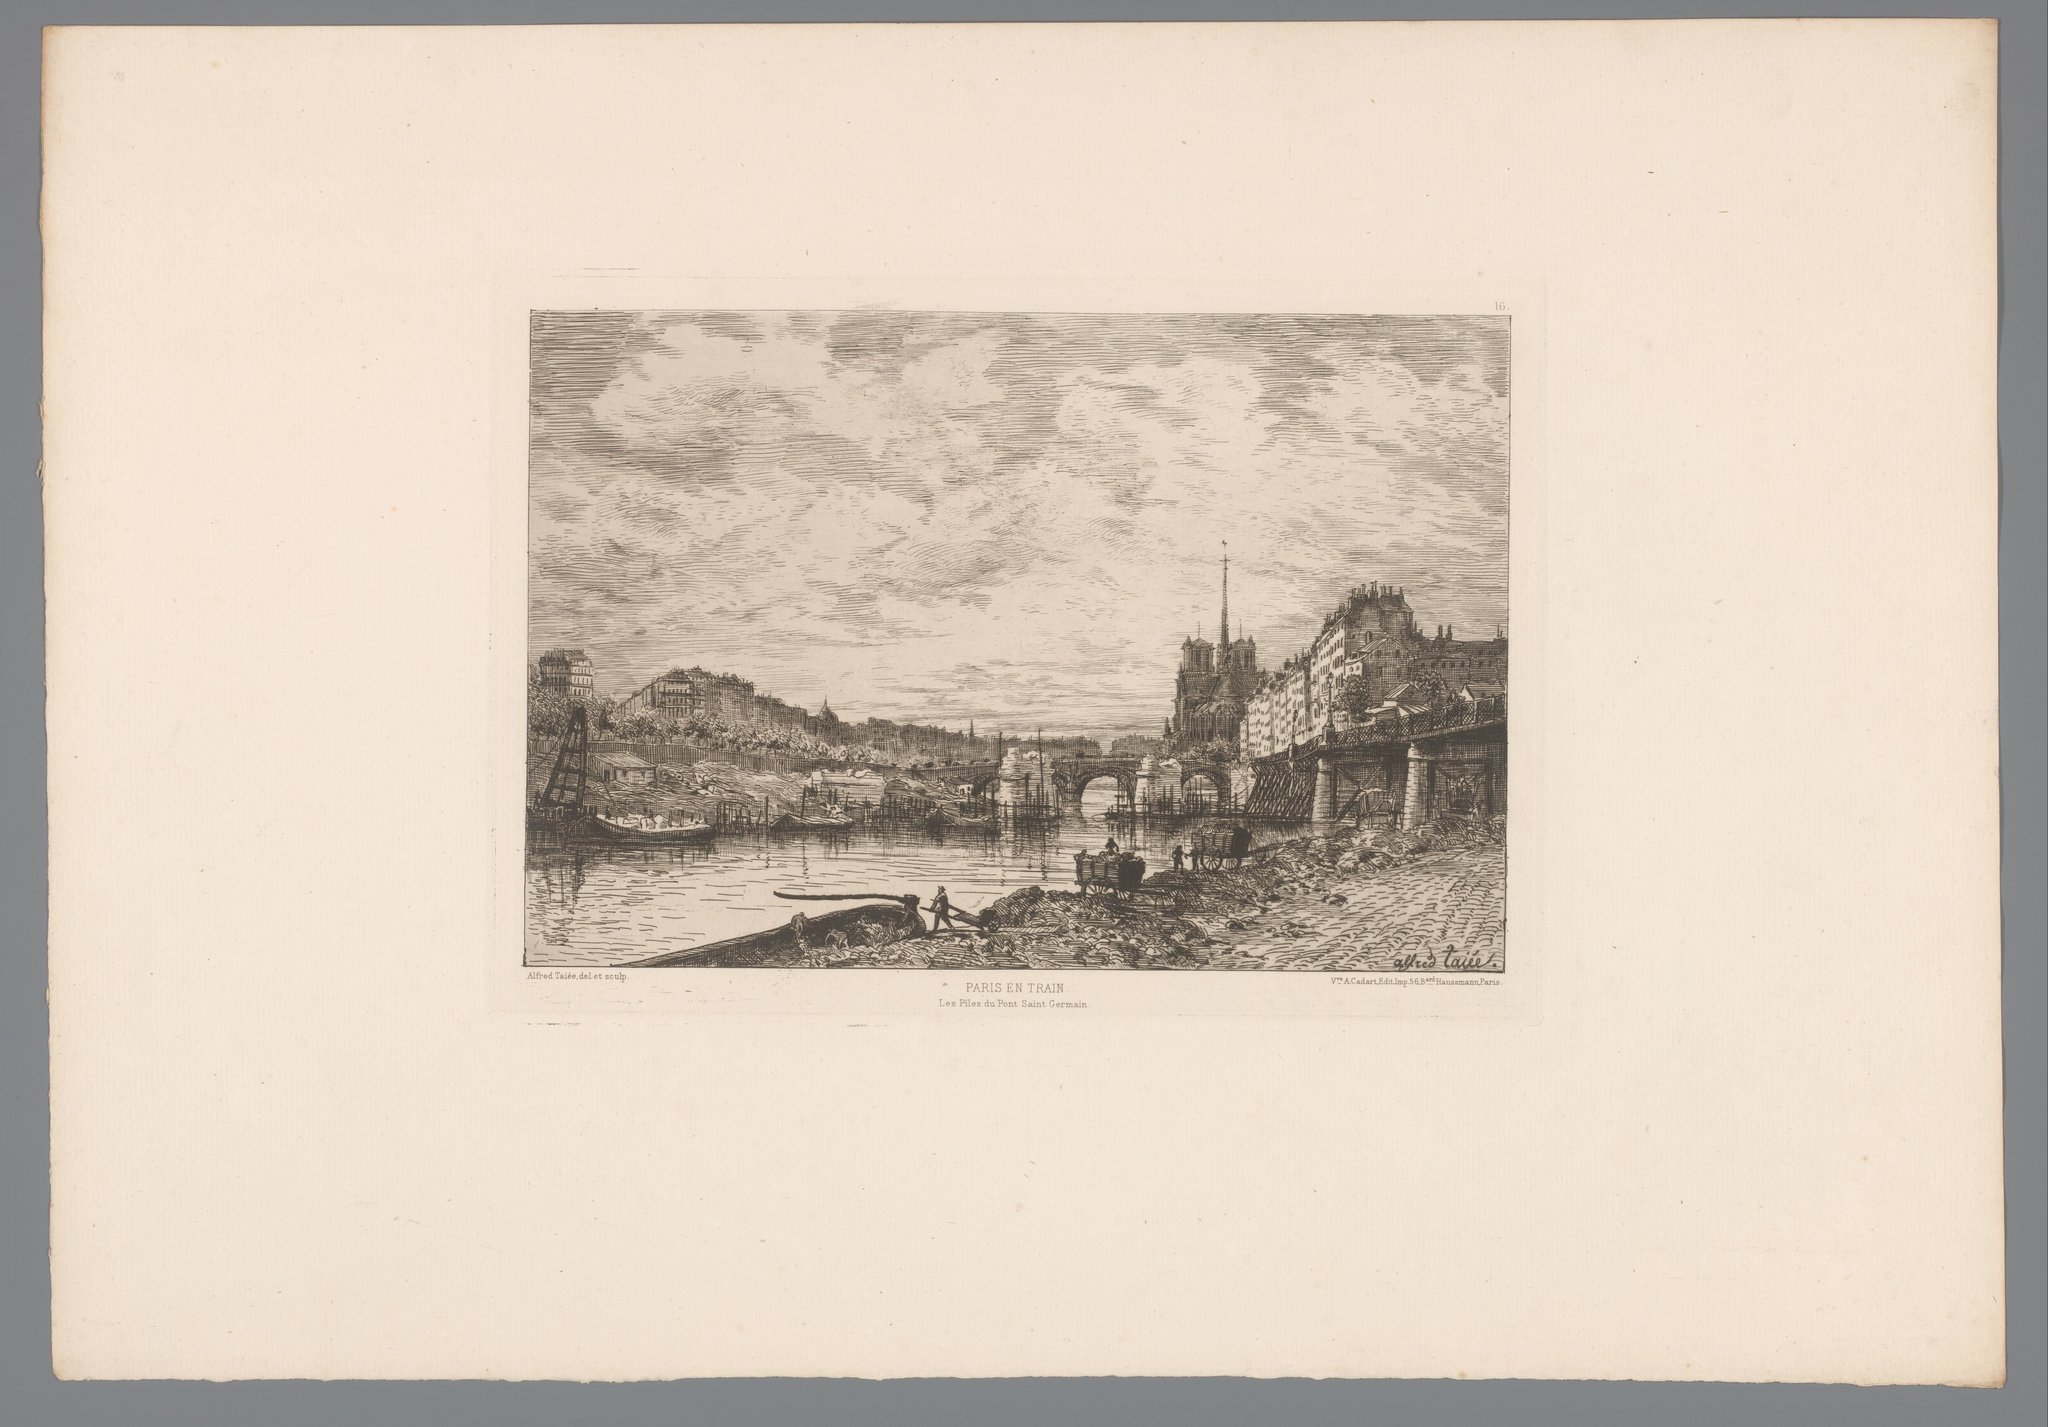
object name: print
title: L'eau-forte en 1876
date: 1876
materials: paper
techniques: drypoint, etching, intaglio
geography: paris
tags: bridge in city across river, canal, etc., paris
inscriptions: collector's mark: ‘AFE v S’, watermark, collector's mark: Lugt 2228, collector's mark: Lugt 2760